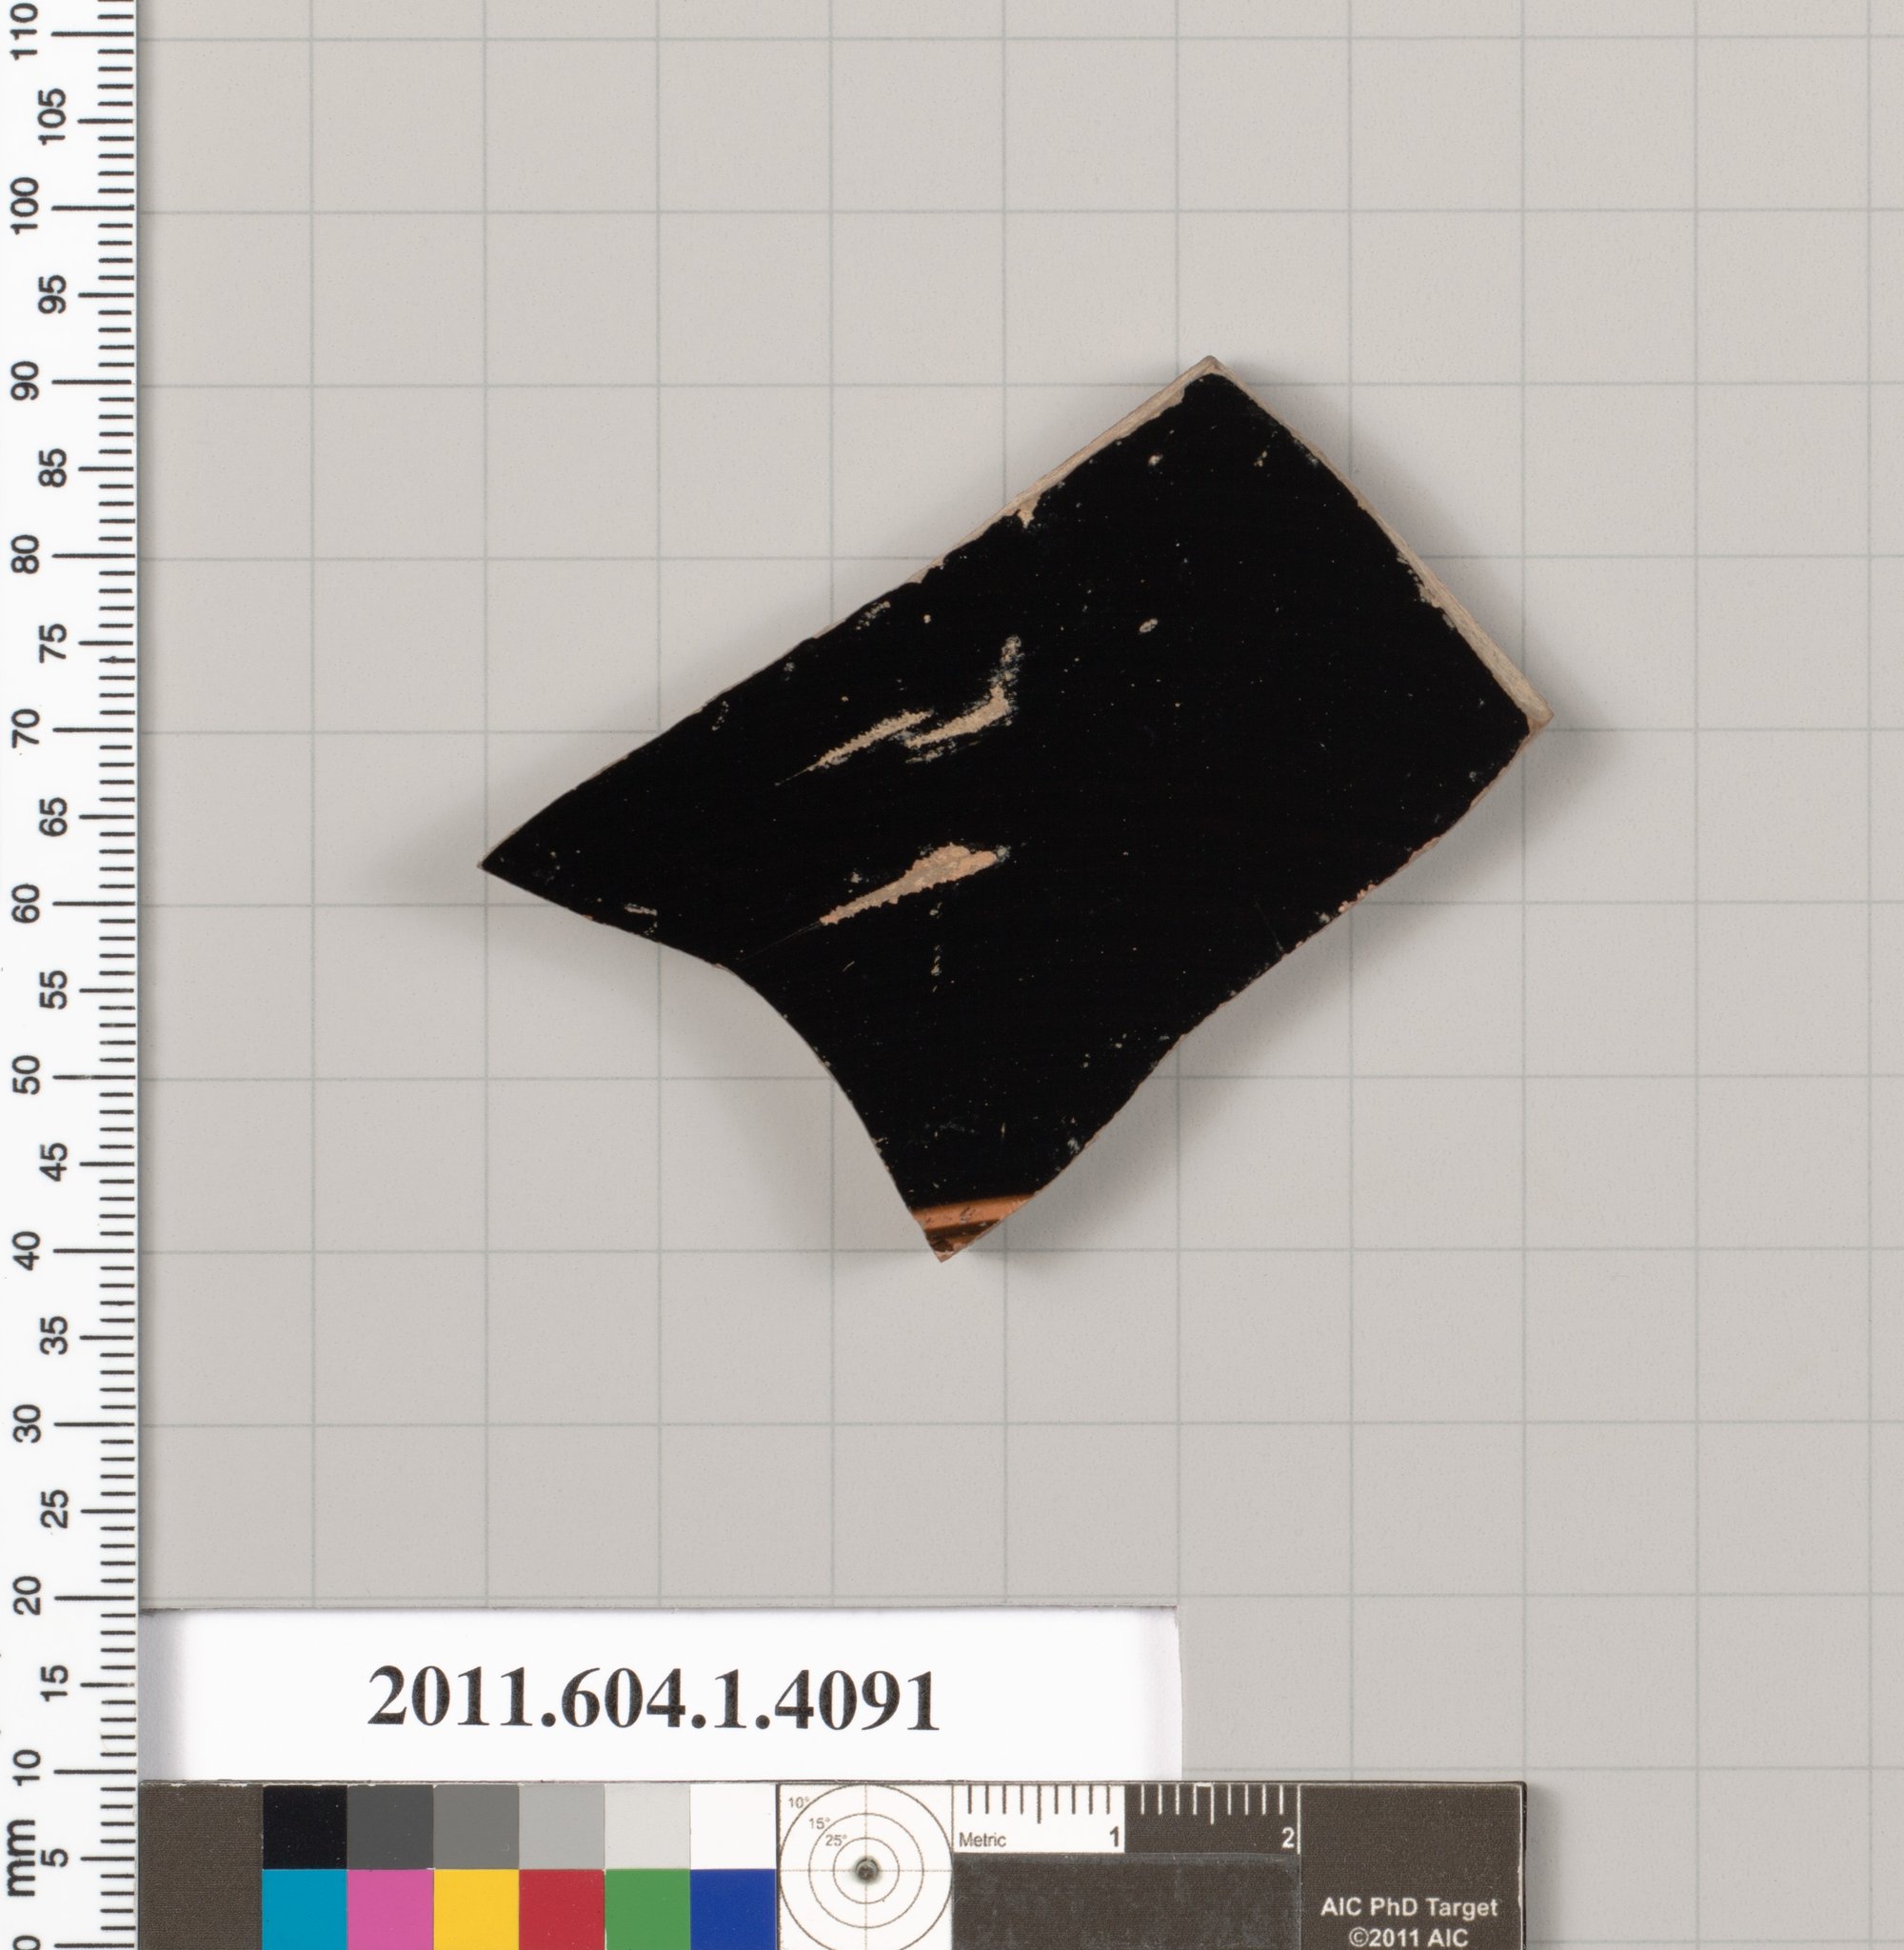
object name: kylix fragment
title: Terracotta fragment of a kylix (drinking cup)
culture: greek, attic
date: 520-500 BCE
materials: terracotta